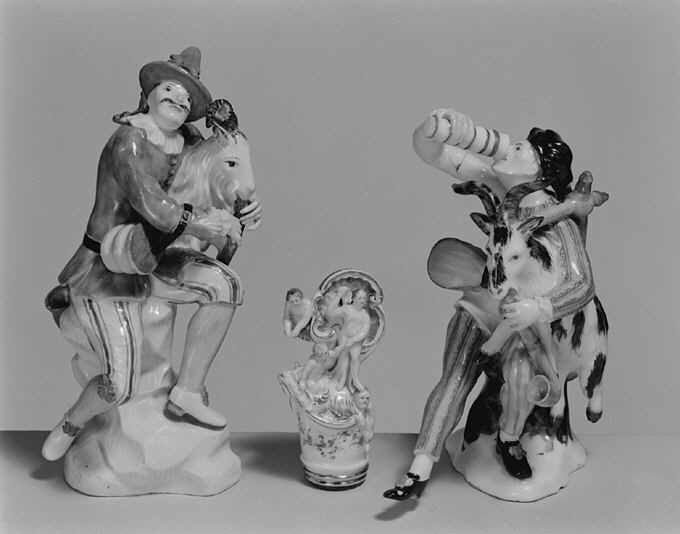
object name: group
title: Musician with goat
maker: höchst manufactory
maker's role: manufactory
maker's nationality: german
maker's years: 1746-1796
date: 1755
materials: hard paste porcelain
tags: men,goats